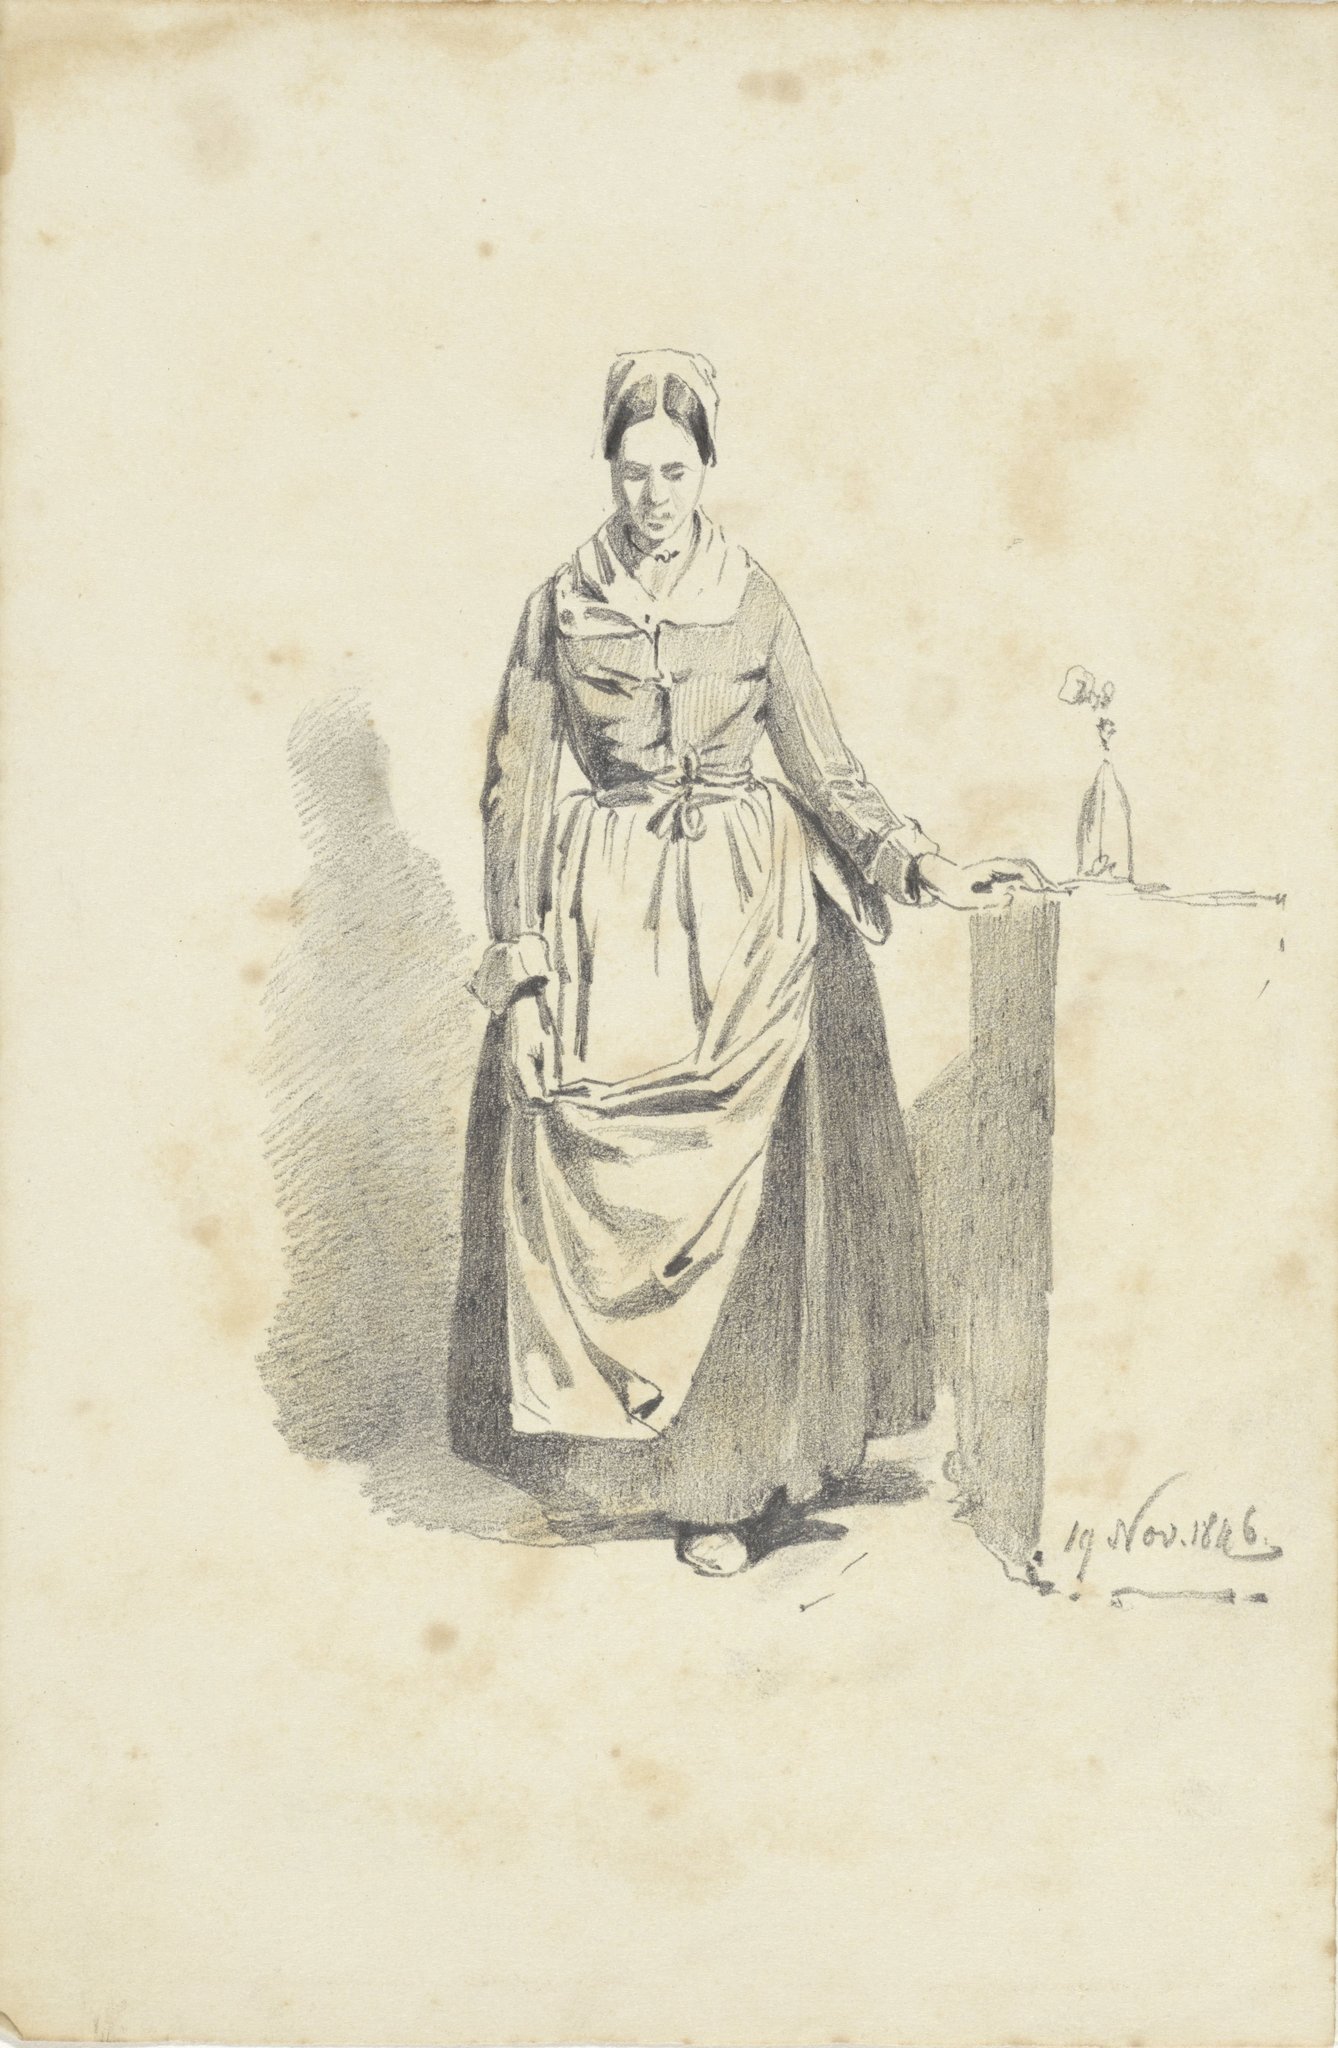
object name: drawing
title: Staande vrouw, van voren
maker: pieter van loon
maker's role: draughtsman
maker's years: 1801-1873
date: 1846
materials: paper, pencil